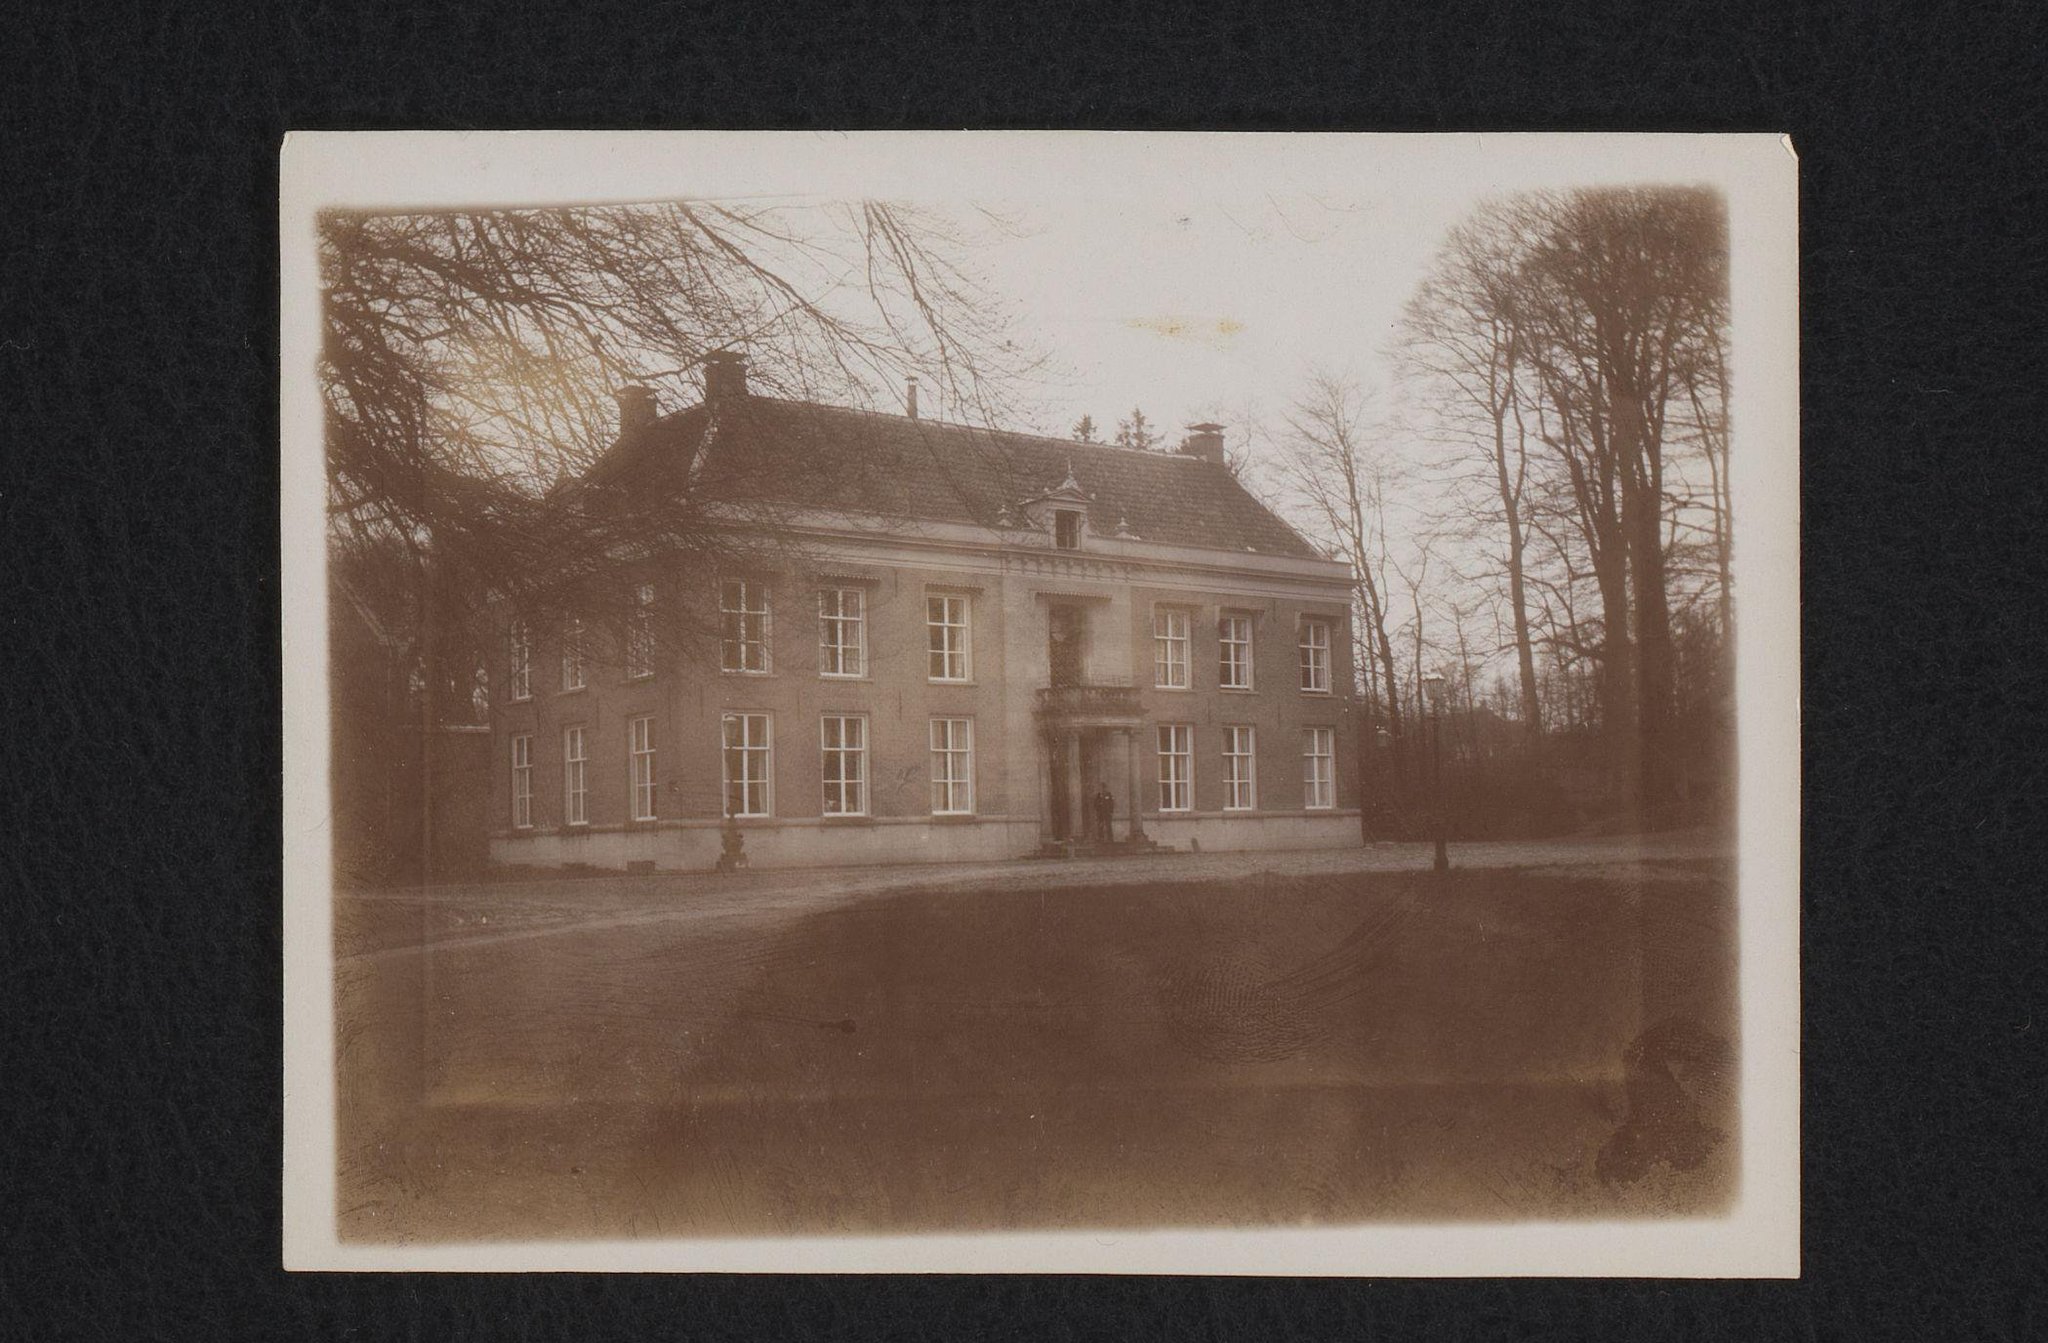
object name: photograph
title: Gezicht op een landhuis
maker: Anonymous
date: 1880-1910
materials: photographic support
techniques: collodion silver print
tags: rural housing, e.g. country-house, villa, cottage